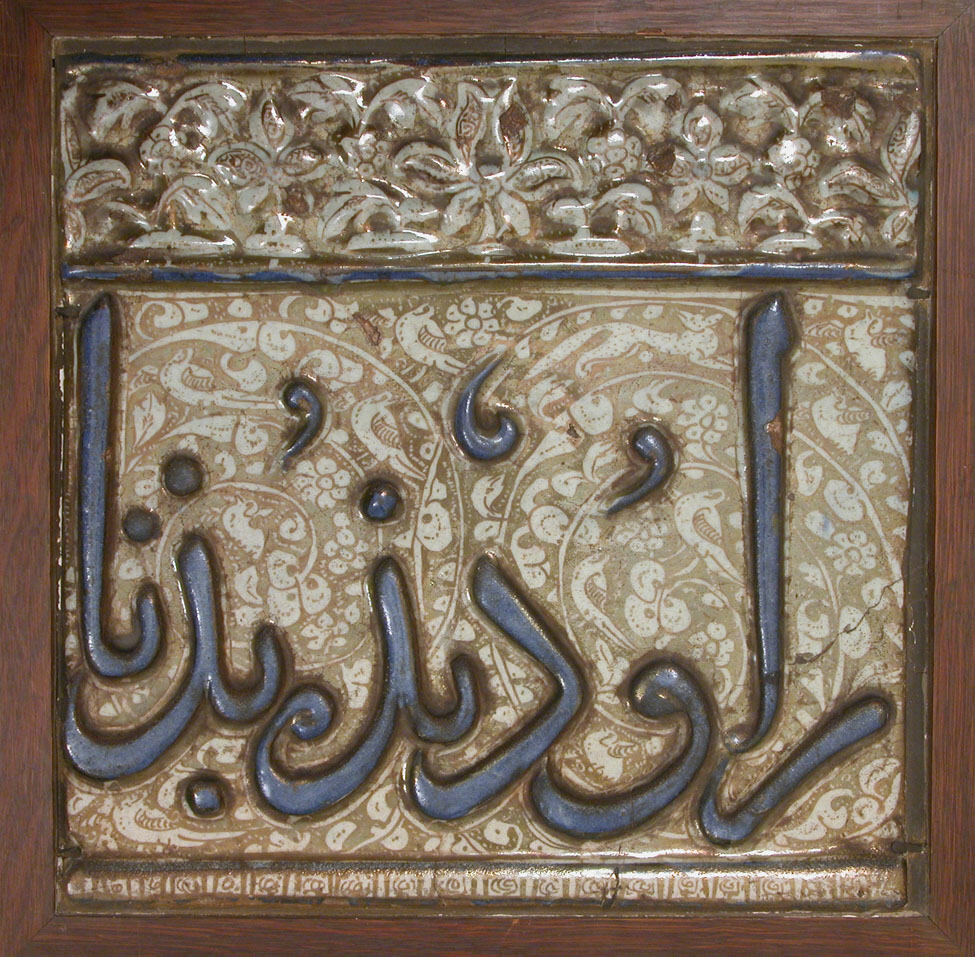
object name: tile from a frieze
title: Tile from an Inscriptional Frieze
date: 1301-1333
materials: glaze, stonepaste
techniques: luster painting, painting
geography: iran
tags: lotuses